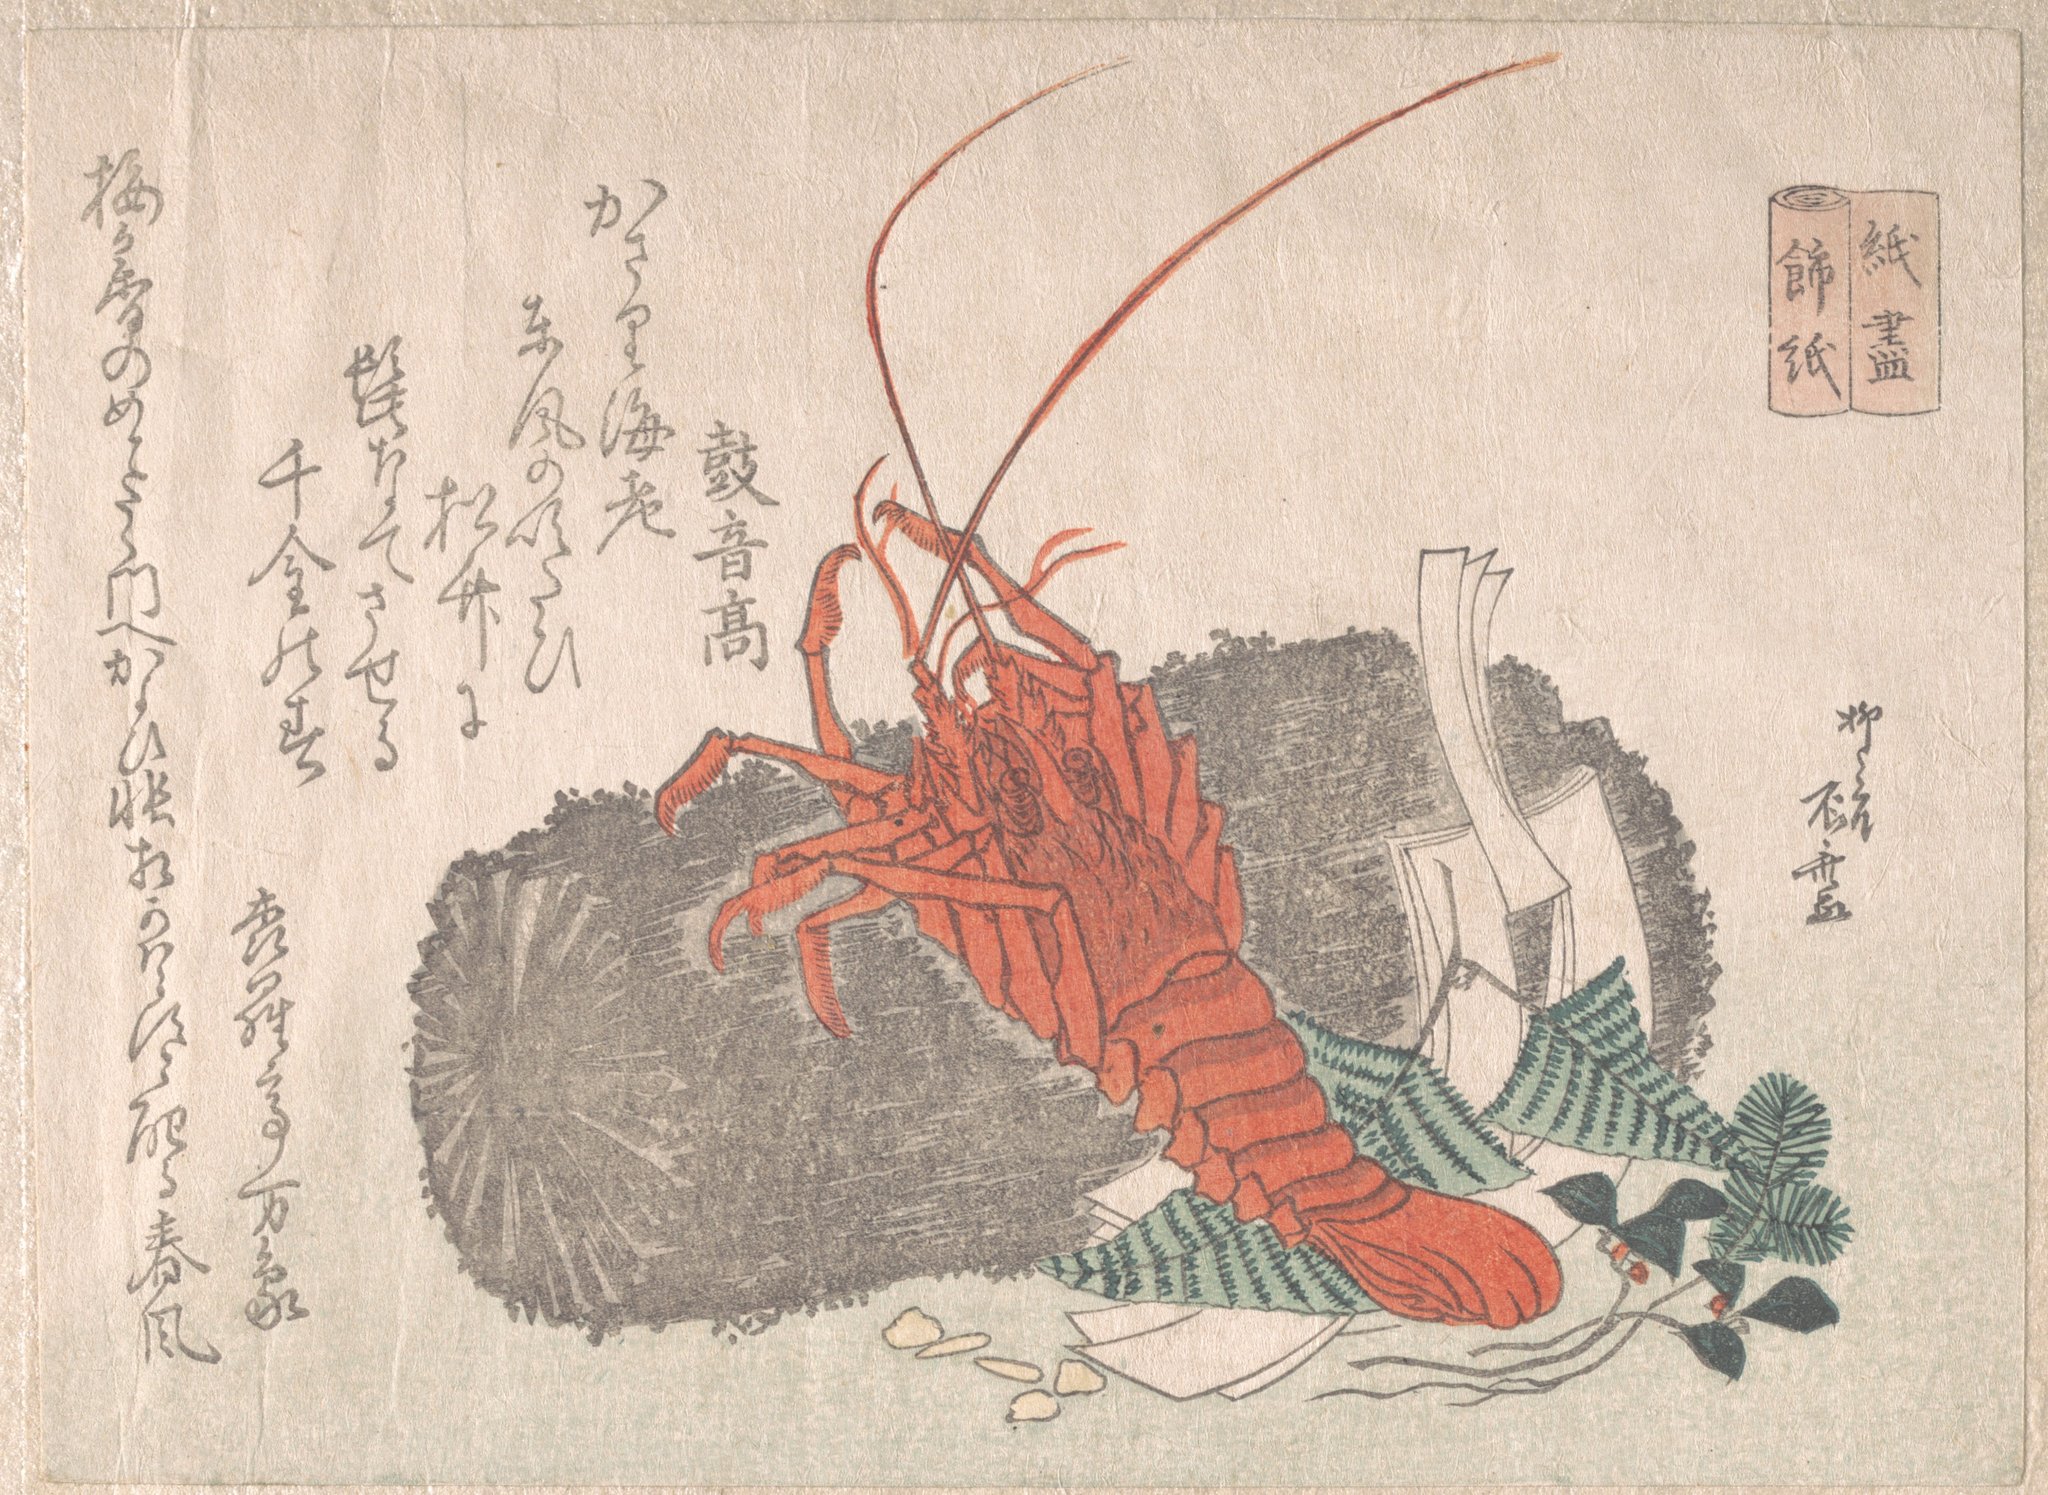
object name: print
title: Lobster on a Piece of Charcoal with Other New Year Decorations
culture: japanese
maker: ryūryūkyo shinsai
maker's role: artist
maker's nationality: japanese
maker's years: 1799-1823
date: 1801-1900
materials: ink, paper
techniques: surimono, woodblock print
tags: lobsters